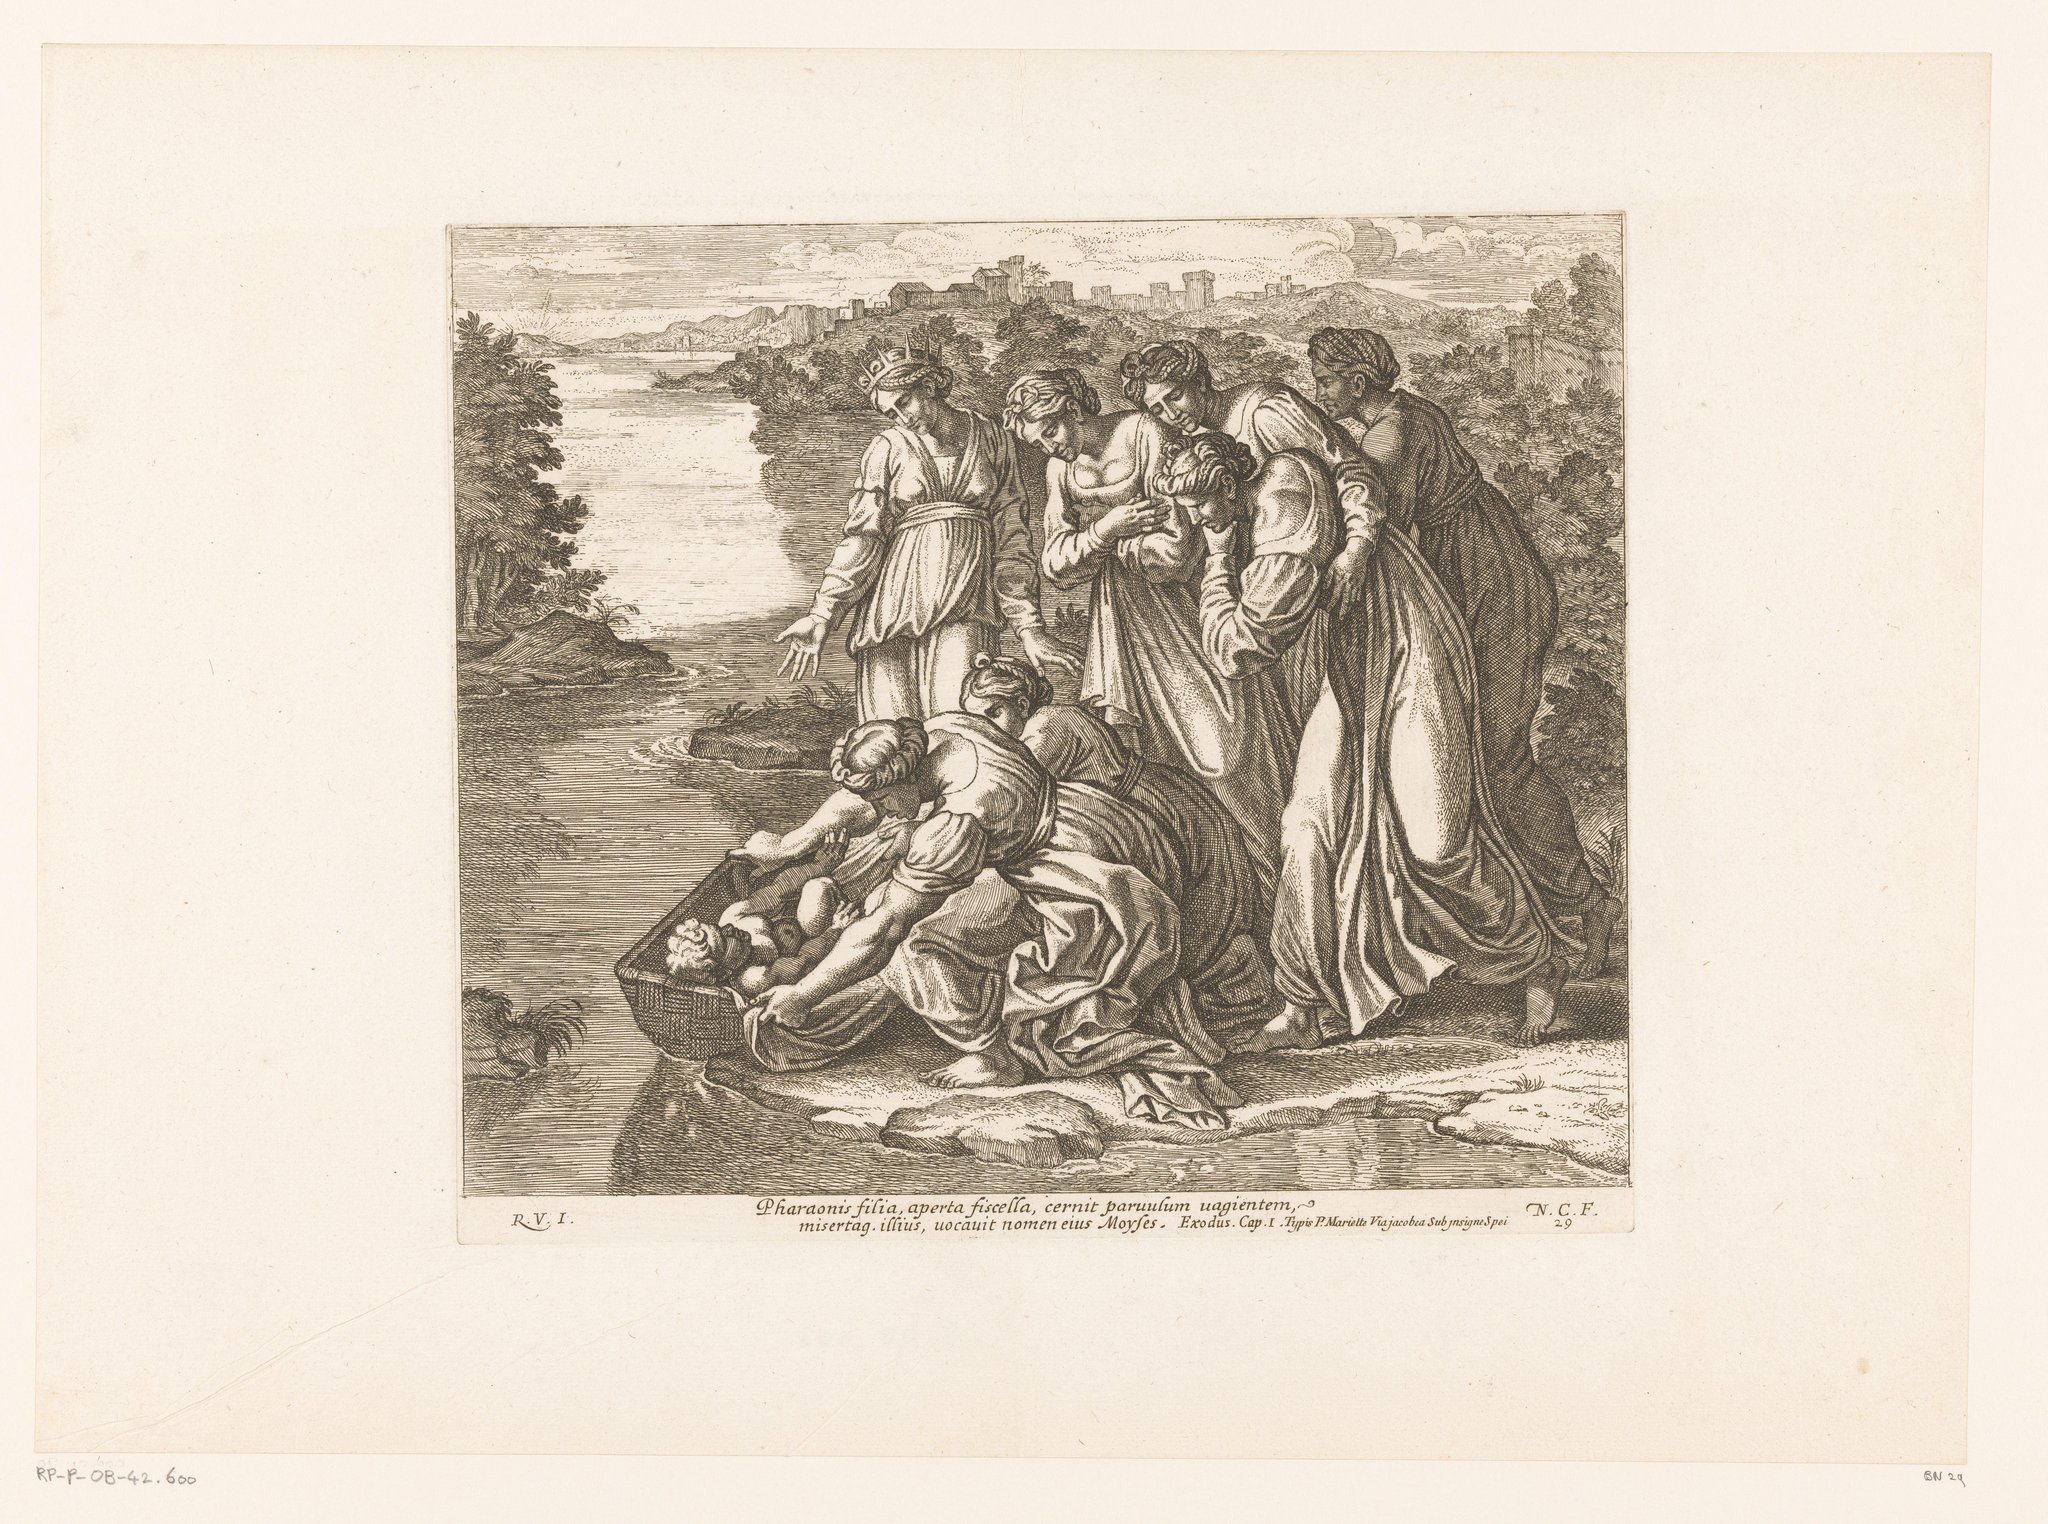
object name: print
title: Sacrae Historiae Acta a Raphael Urbin in Vaticanis xystis ad picturae miraculum expressa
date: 1649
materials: paper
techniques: etching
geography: vatican city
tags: moses is pulled out of the water by the servants, the finding of moses: pharaoh's daughter comes to bathe with her maidens in the river and discovers the child floating on the water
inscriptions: collector's mark: Lugt 2228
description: Prent uit de Sacrae Historiae Acta a Raphael Urbin in Vaticanis xystis ad picturae miraculum expressa, ook bekend als de Rafaël Bijbel. De serie bestaat uit 54 platen, waarvan twee titelprenten, de eerste met een opdracht aan Rafaël, de tweede met een opdracht aan Renard. De overige 52 platen betreffen composities naar schilderingen in de Loggia van Rafaël in het Vaticaan. De serie werd in 1649 uitgegeven door Pierre Mariette te Parijs.